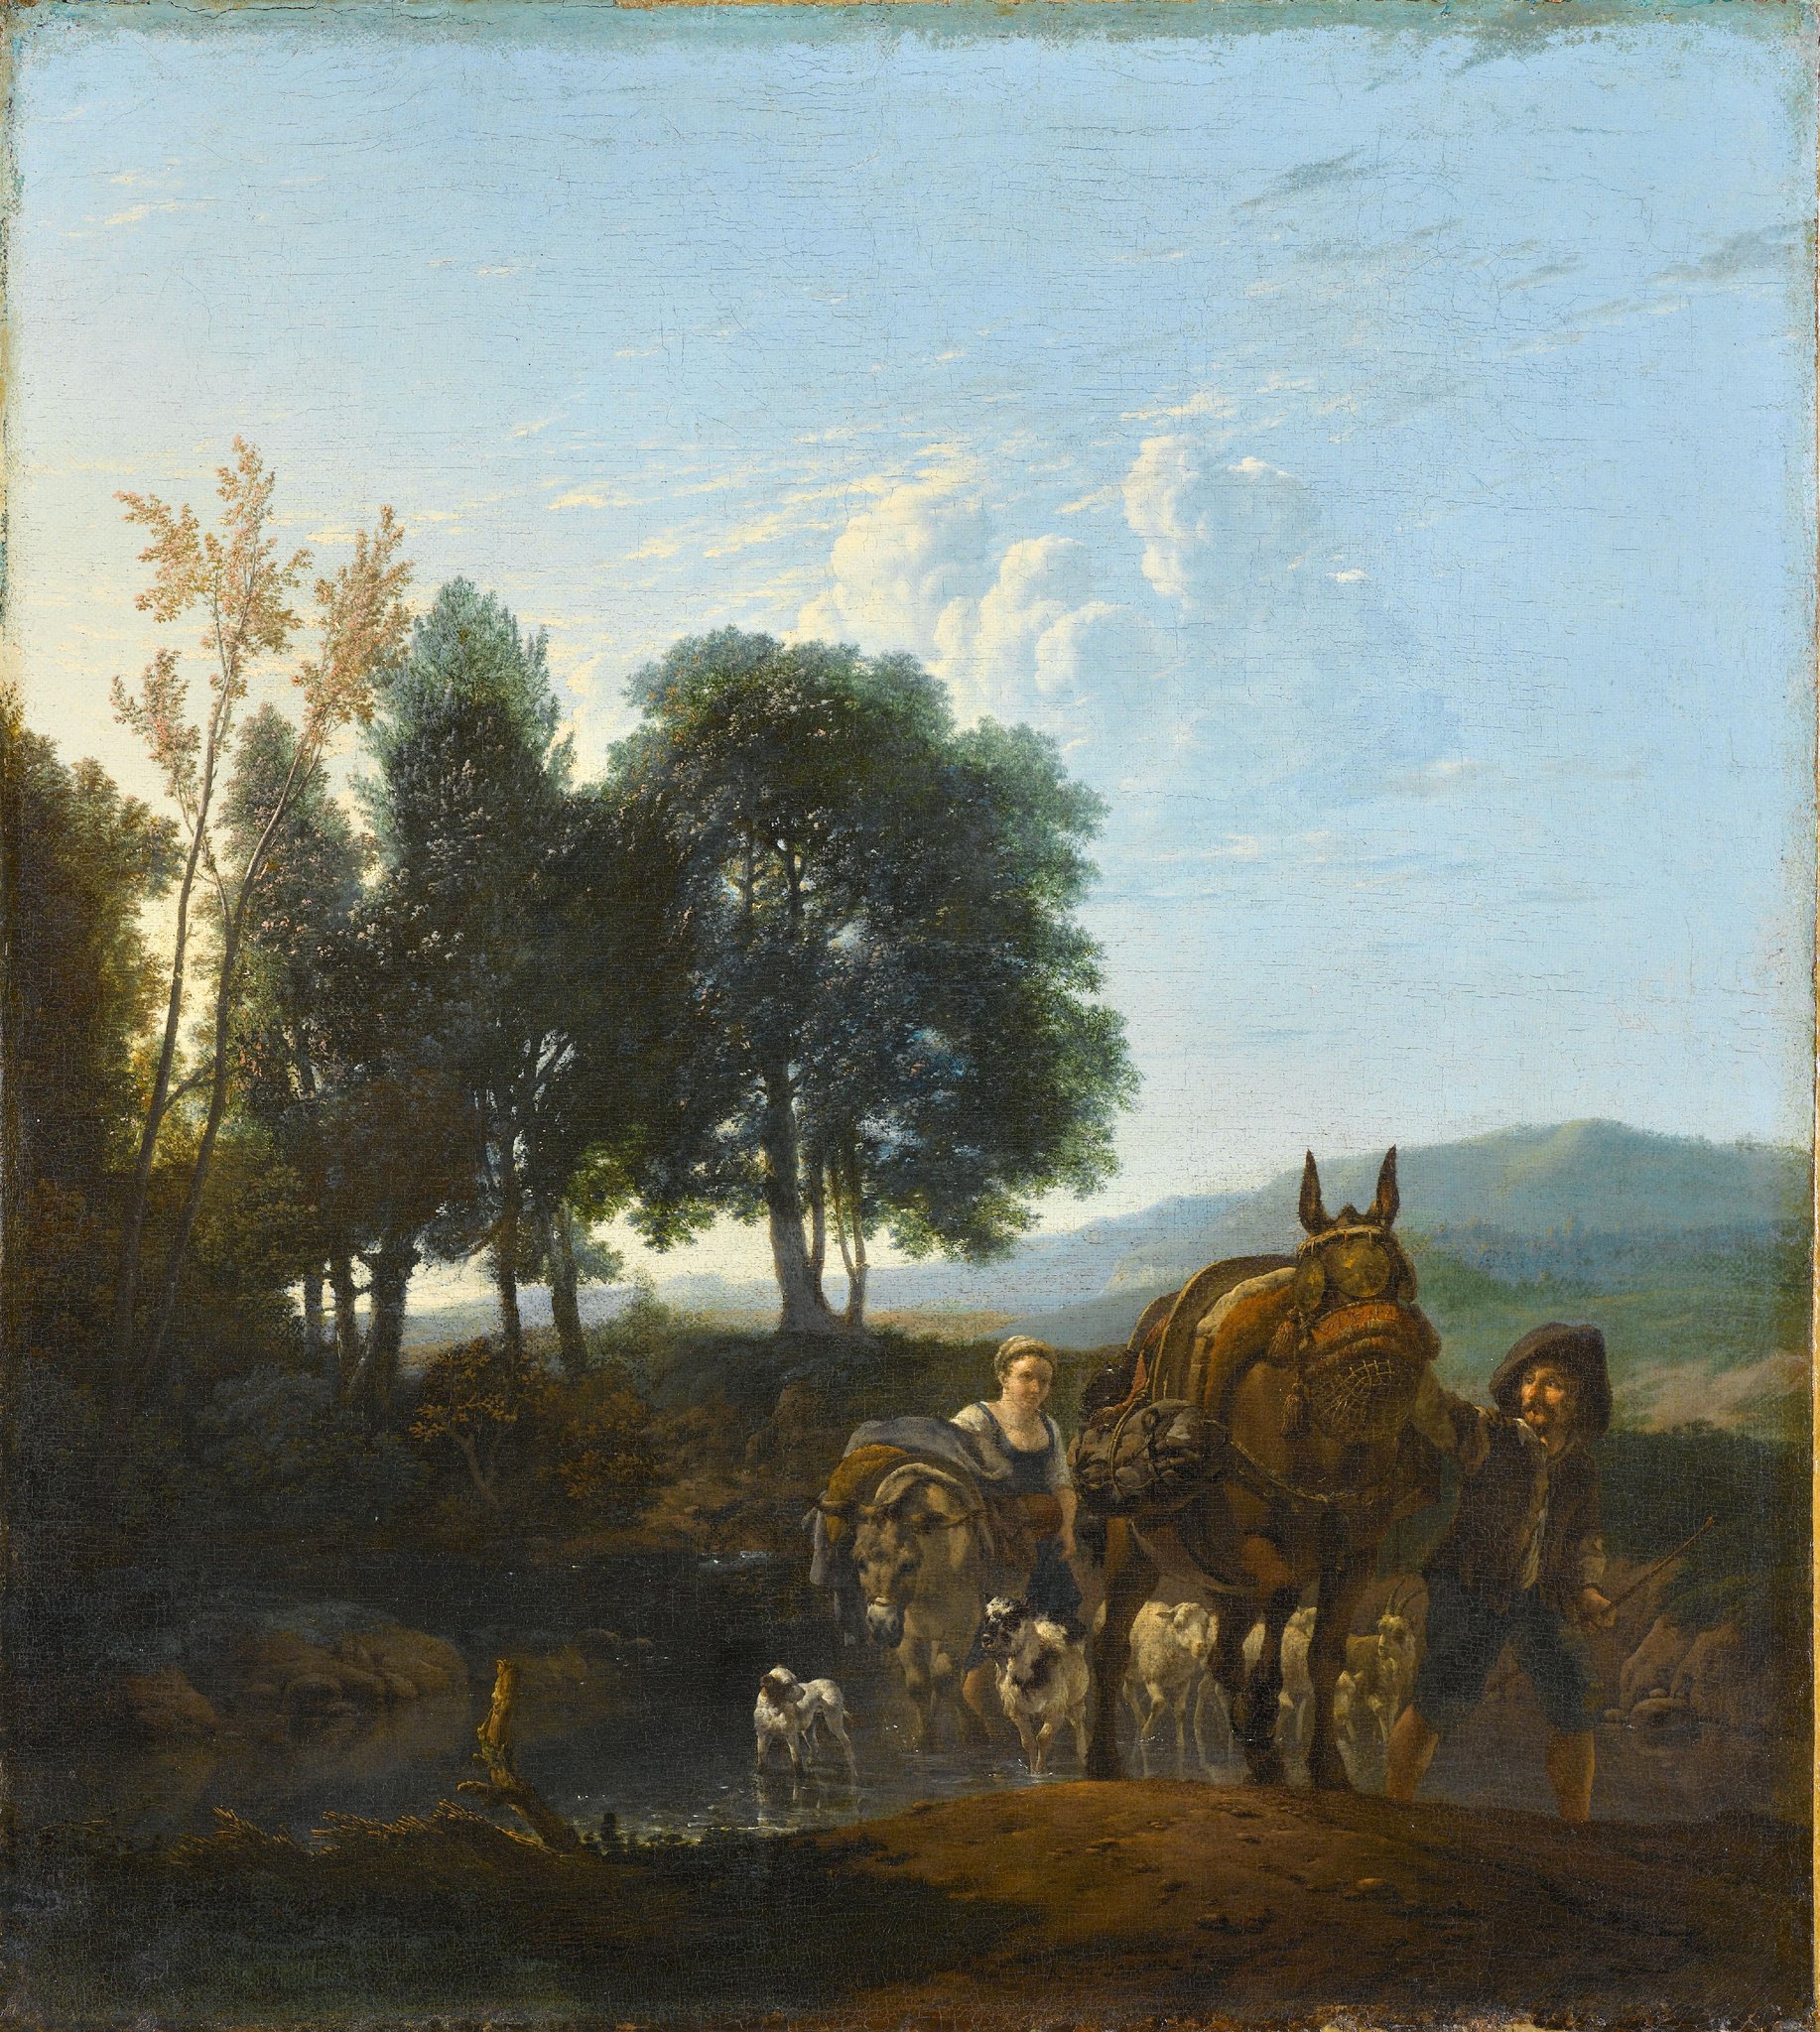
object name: painting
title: Landscape with Mule Driver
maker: karel du jardin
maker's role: draughtsman, painter, print maker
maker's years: 1626-1678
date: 1650-1655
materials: canvas, oil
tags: herding, herdsman, herdswoman, shepherd, shepherdess, cowherd, etc., mule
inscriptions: signature: ‘K. du. Jardin. f.’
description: Landschap met een muilezeldrijver die met zijn vrouw en vee een plas doorwaadt.